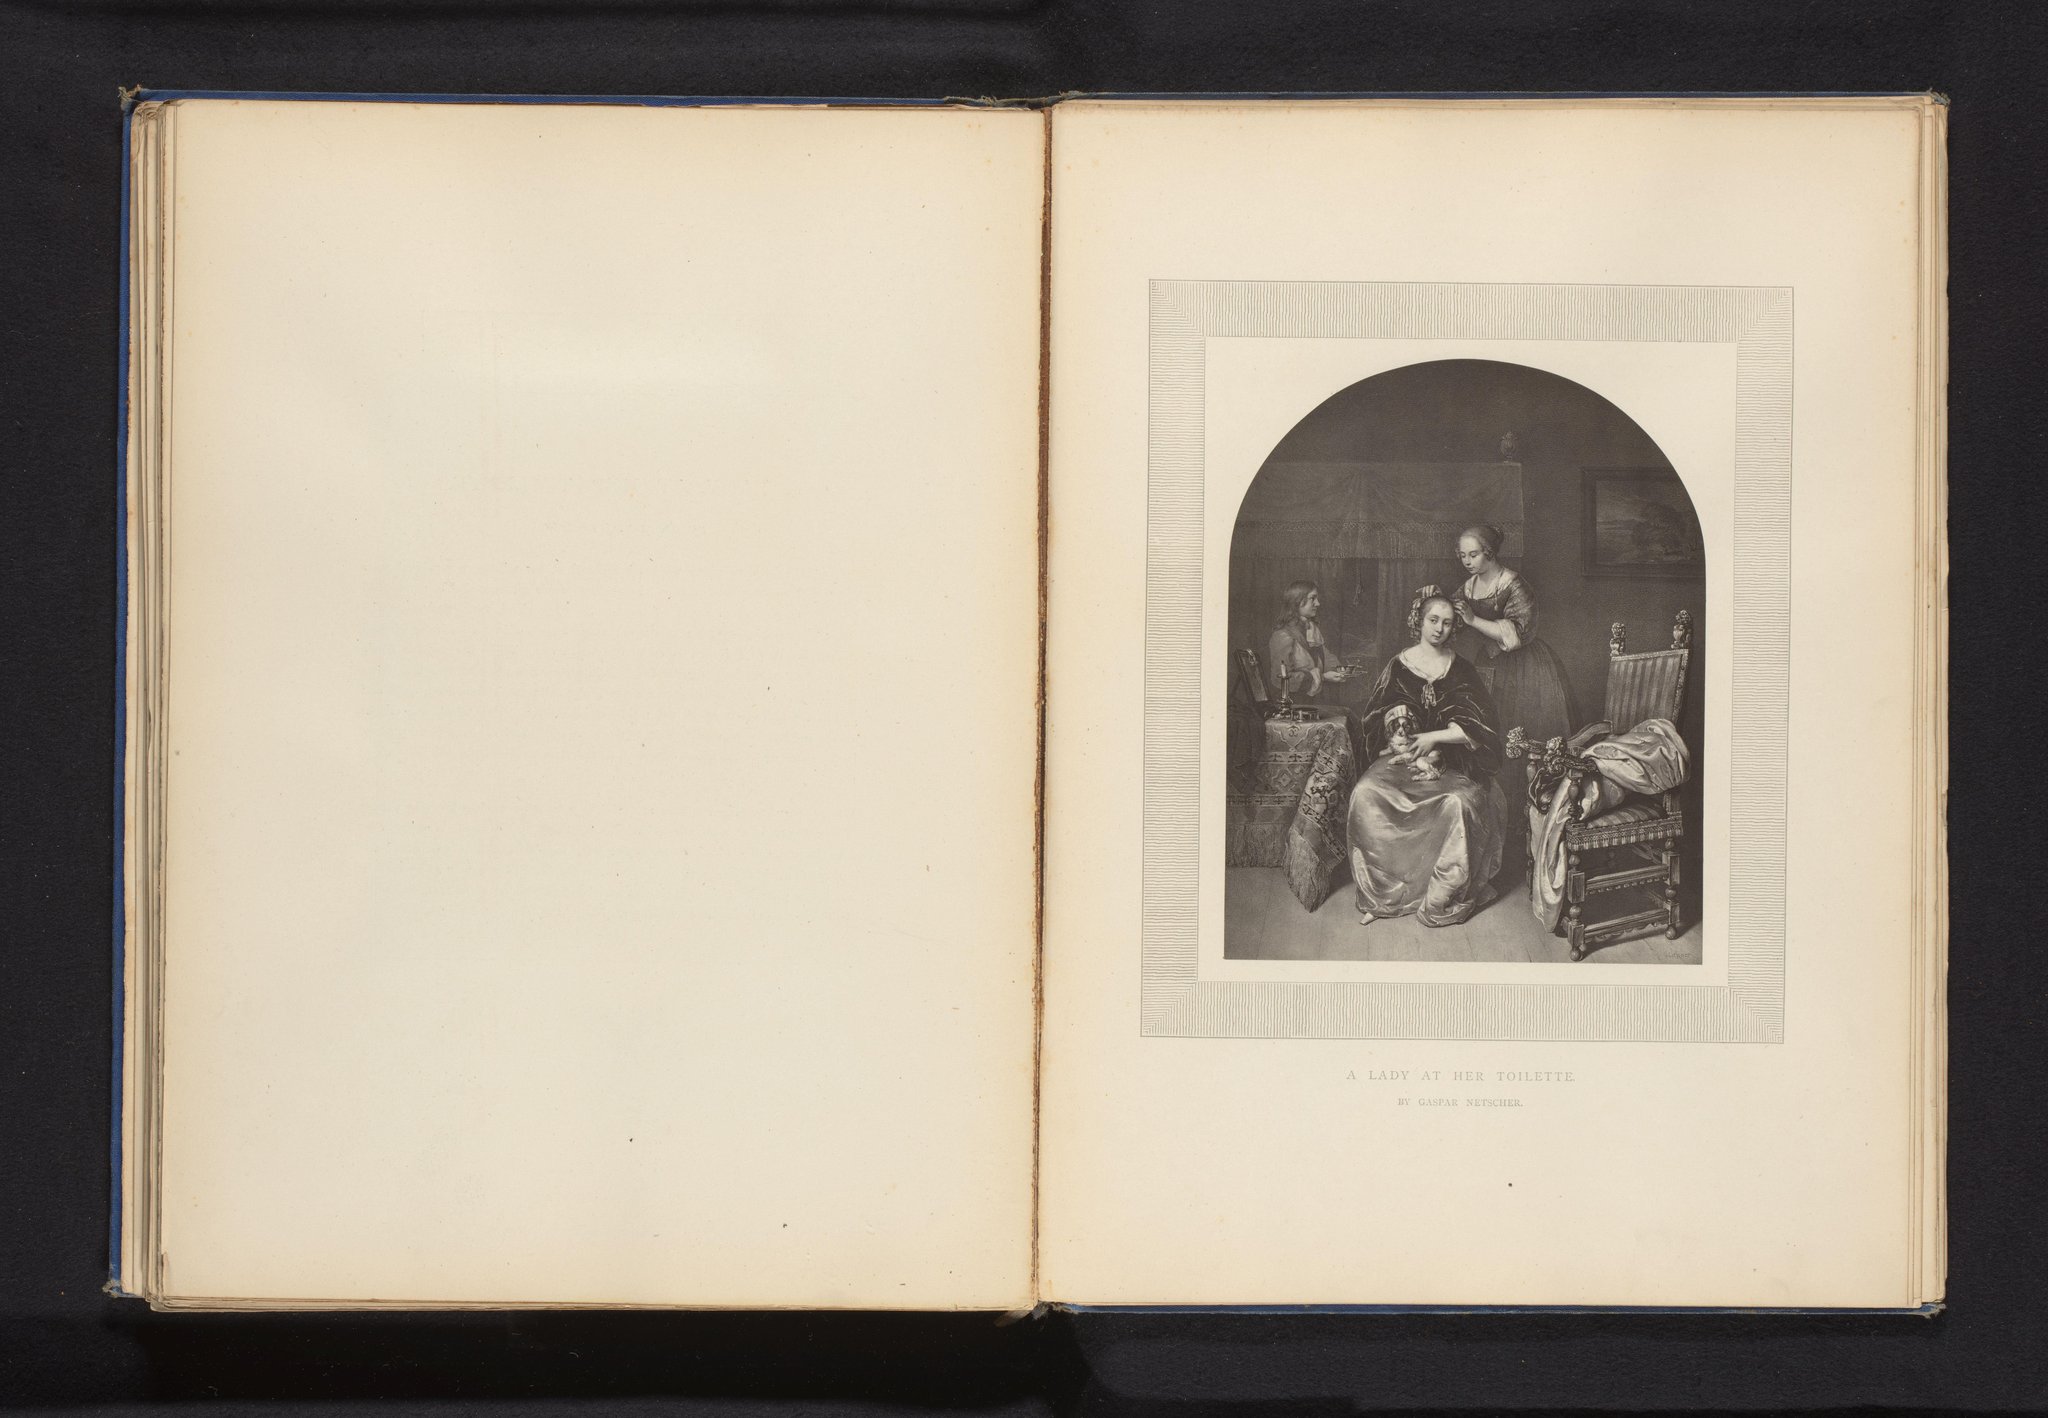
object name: page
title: A lady at her toilette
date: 1870-1875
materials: paper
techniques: woodburytype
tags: sleigh, sledge (non-sport), winter landscape; landscape symbolizing winter (the four seasons of the year)